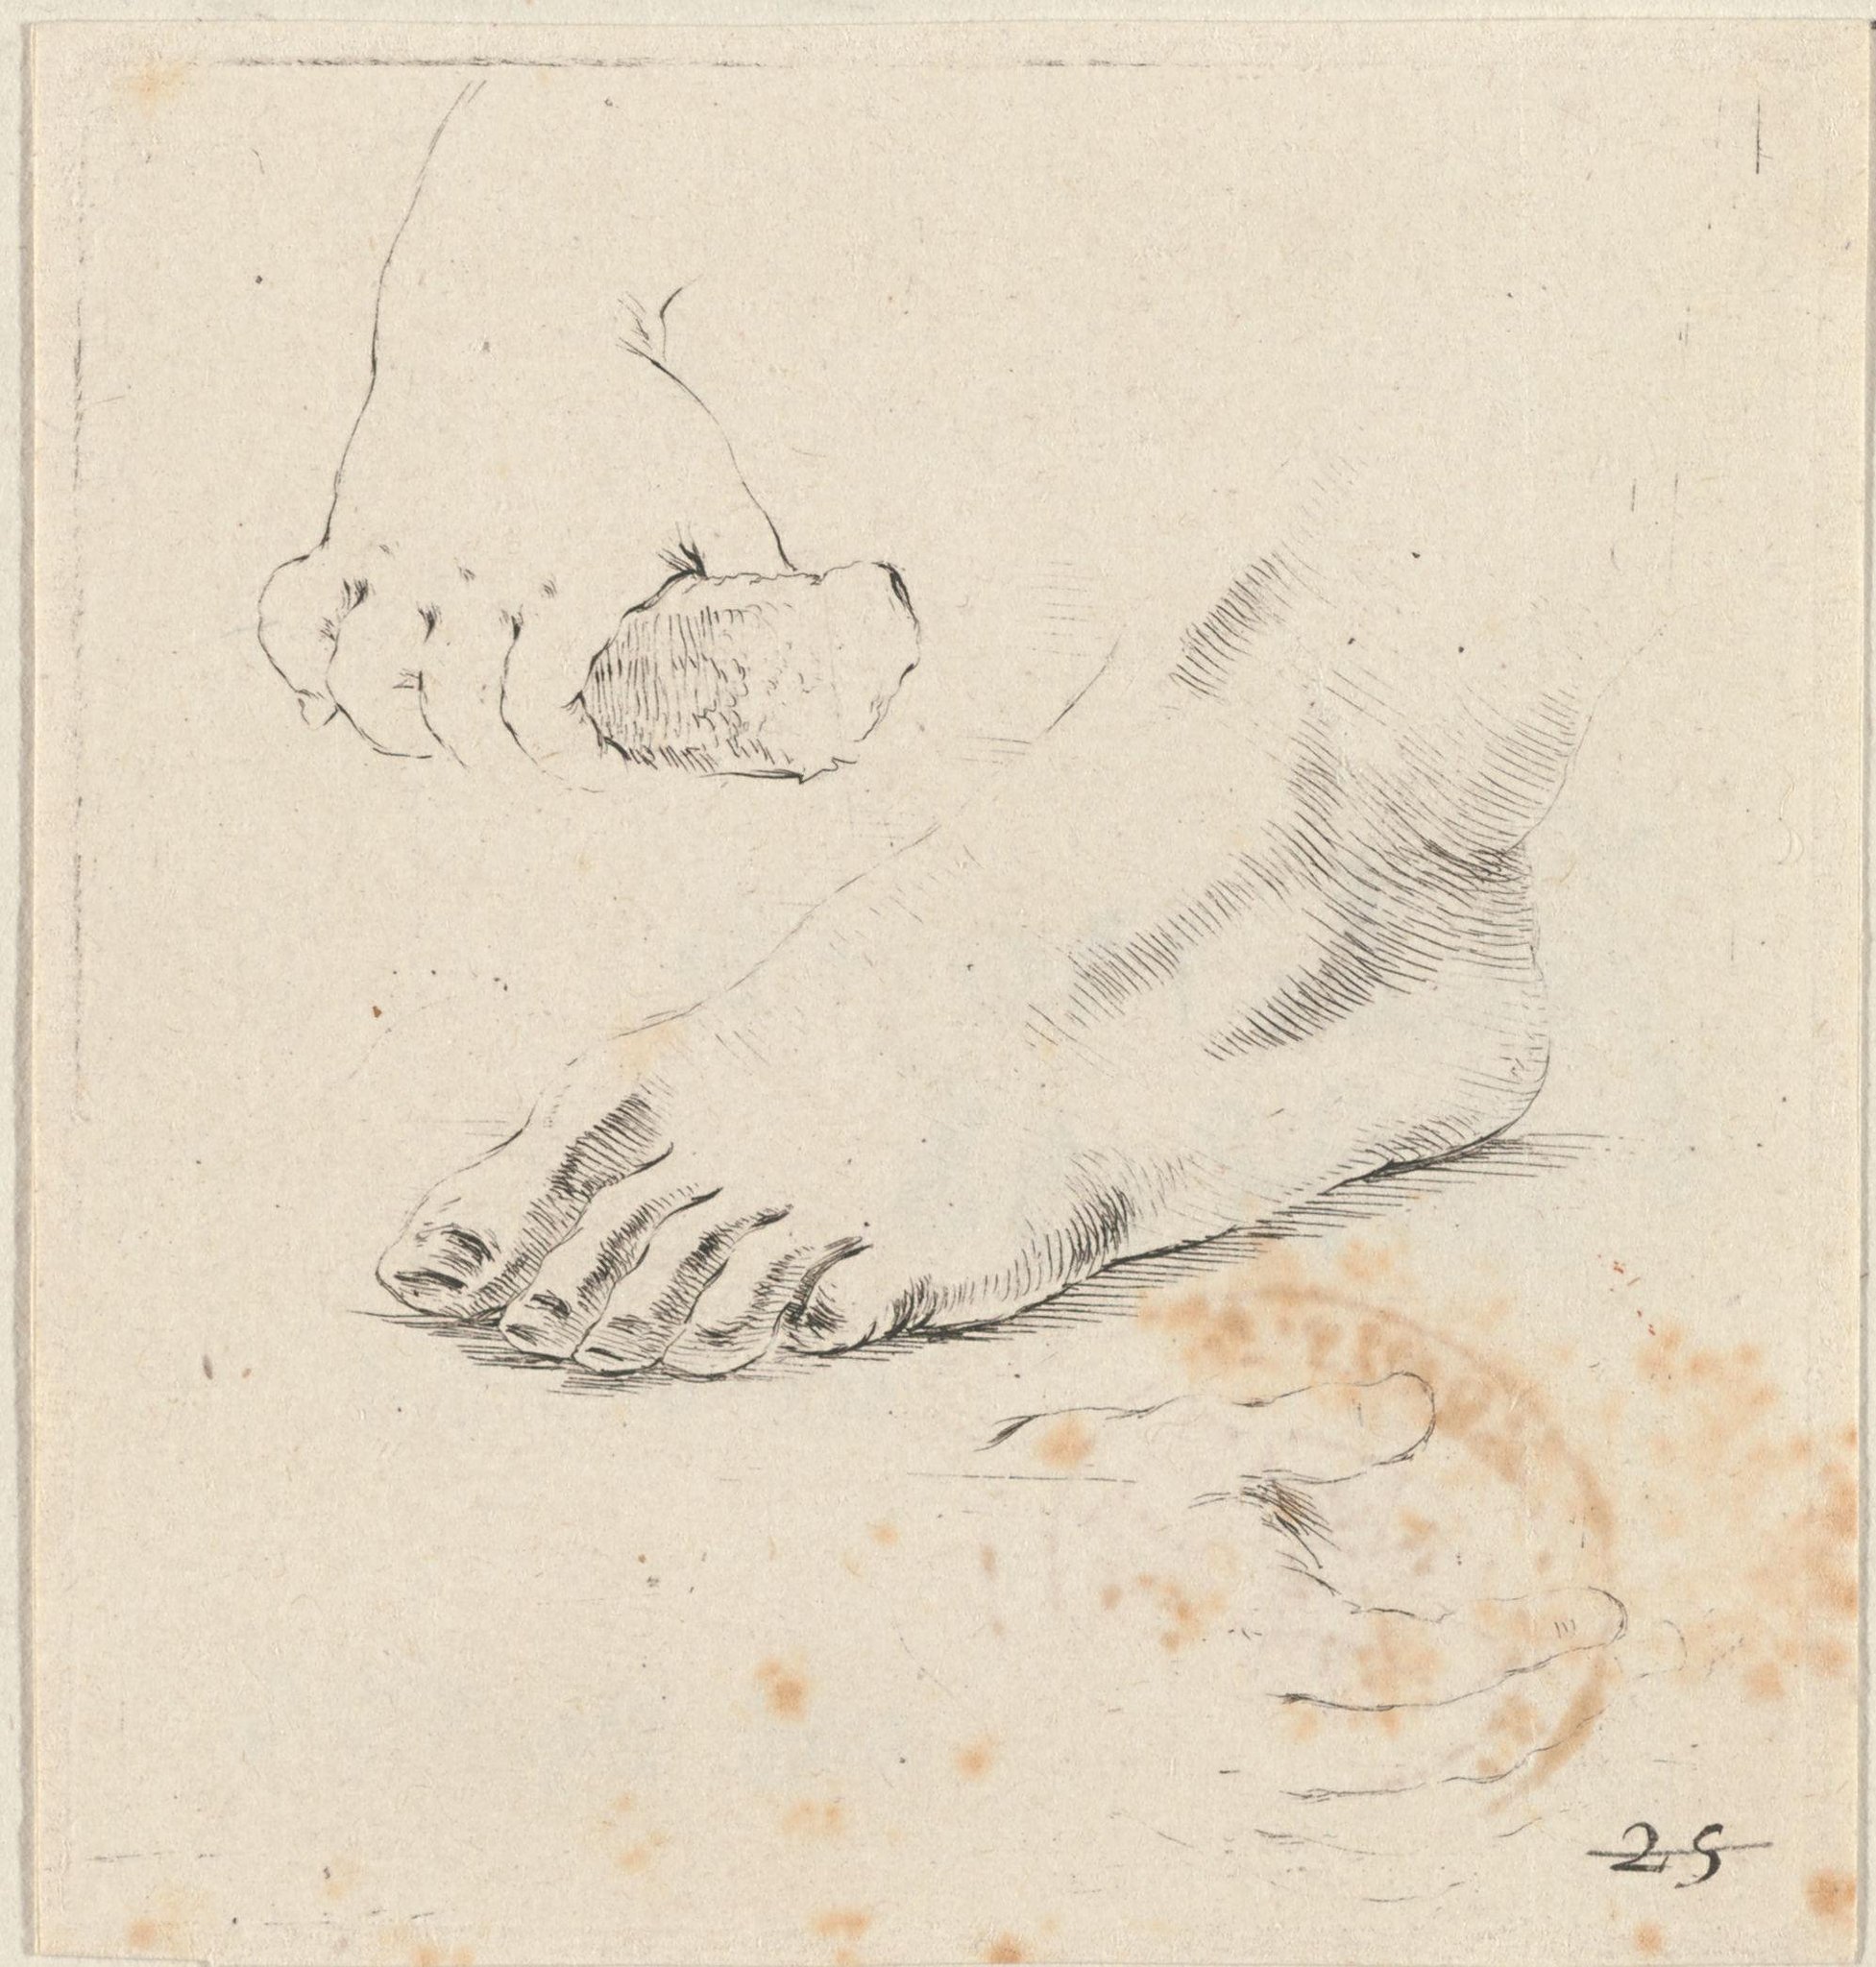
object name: print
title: Twee handen en een voet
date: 1620-1647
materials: paper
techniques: etching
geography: paris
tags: hand, foot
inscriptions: collector's mark: Lugt 240